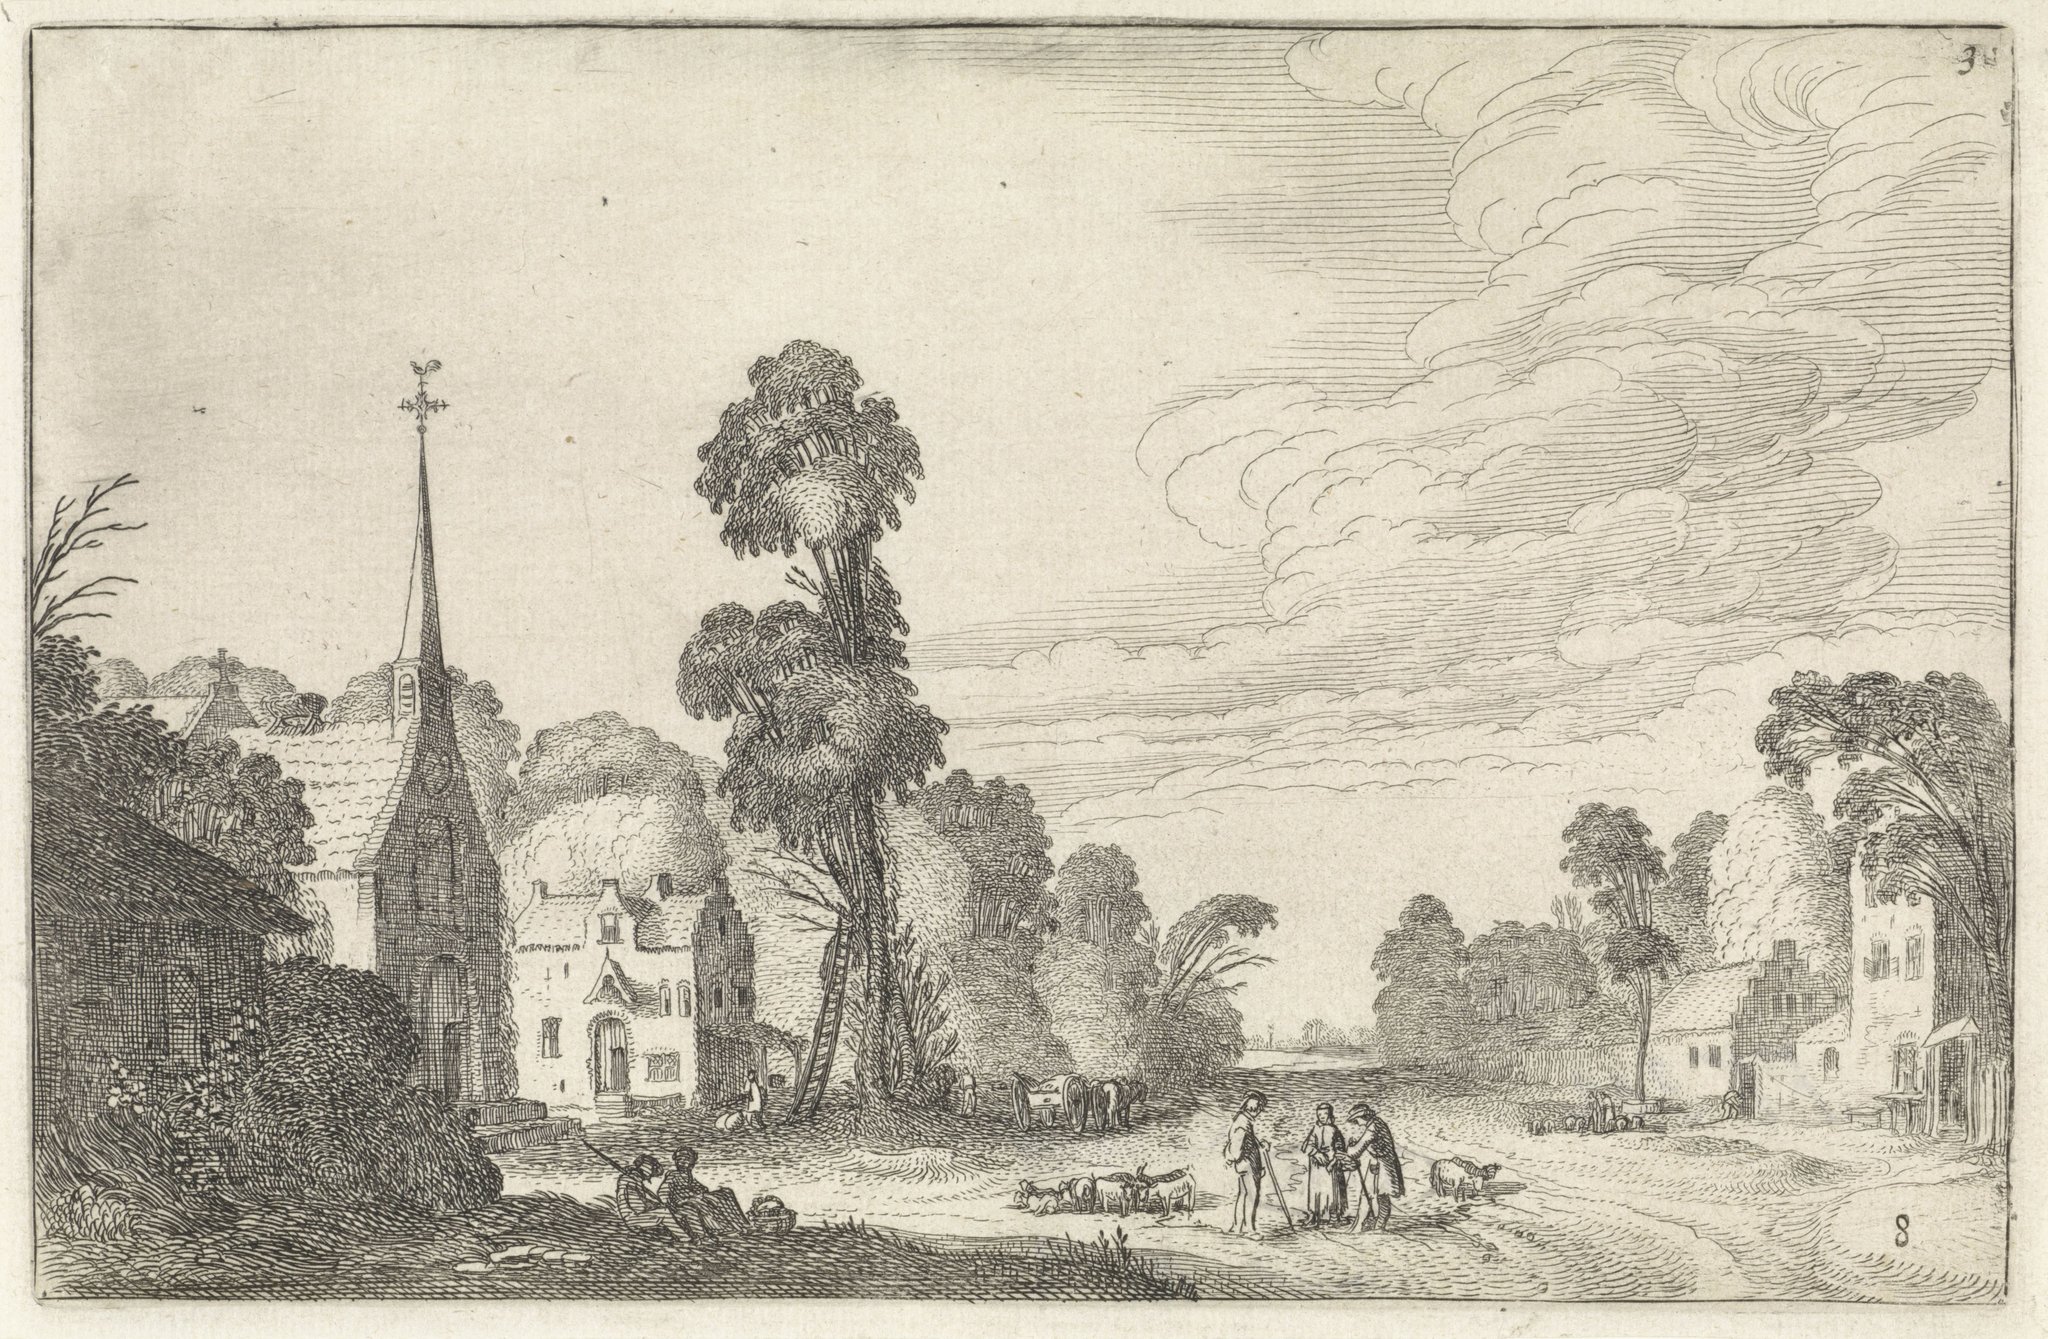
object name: print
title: Amenissimae aliquot requculae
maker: jan van de velde (ii)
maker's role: draughtsman, painter, print maker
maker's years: 1593-1641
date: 1616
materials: paper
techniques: etching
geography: northern netherlands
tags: village, church (exterior), public road in village, herd, flock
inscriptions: collector's mark: Lugt 964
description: Converserende figuren op een weg tussen de huizen van een dorp. Links een kerk. Op de voorgrond twee zittende figuren. Achtste prent van deel drie van een serie van in totaal zestig prenten met landschappen, verdeeld over vijf delen van elk twaalf prenten.